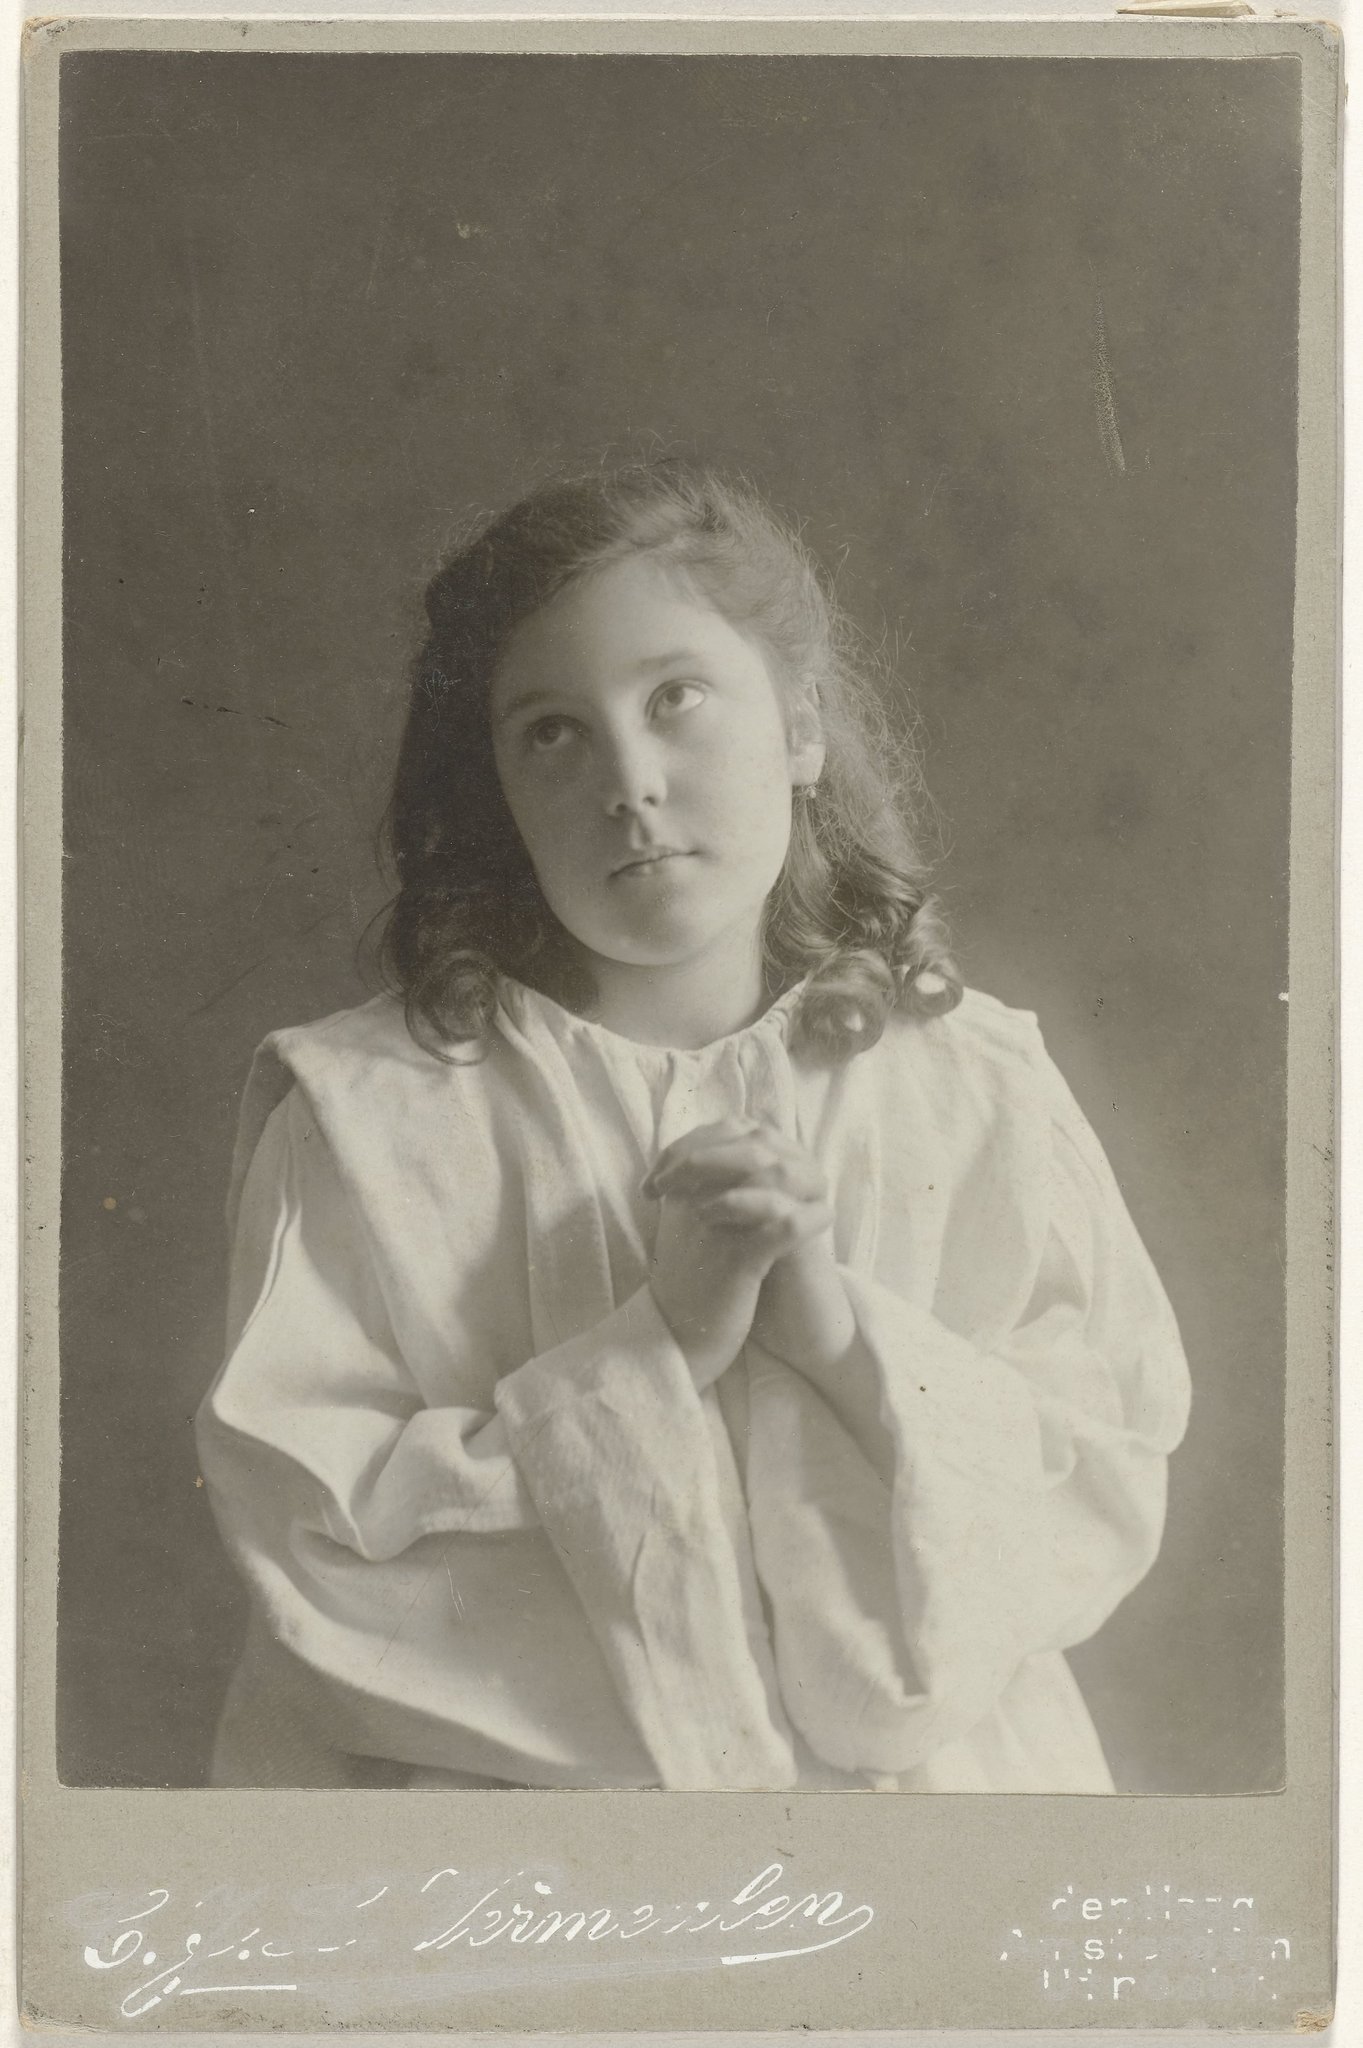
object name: photograph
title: Studioportret van Tine Kleiterp als biddend meisje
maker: cornelis johannes lodewicus vermeulen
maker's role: fotograaf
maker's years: 1861-1936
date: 1910-1930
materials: cardboard, photographic support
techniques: gelatin silver print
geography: amsterdam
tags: dress, gown